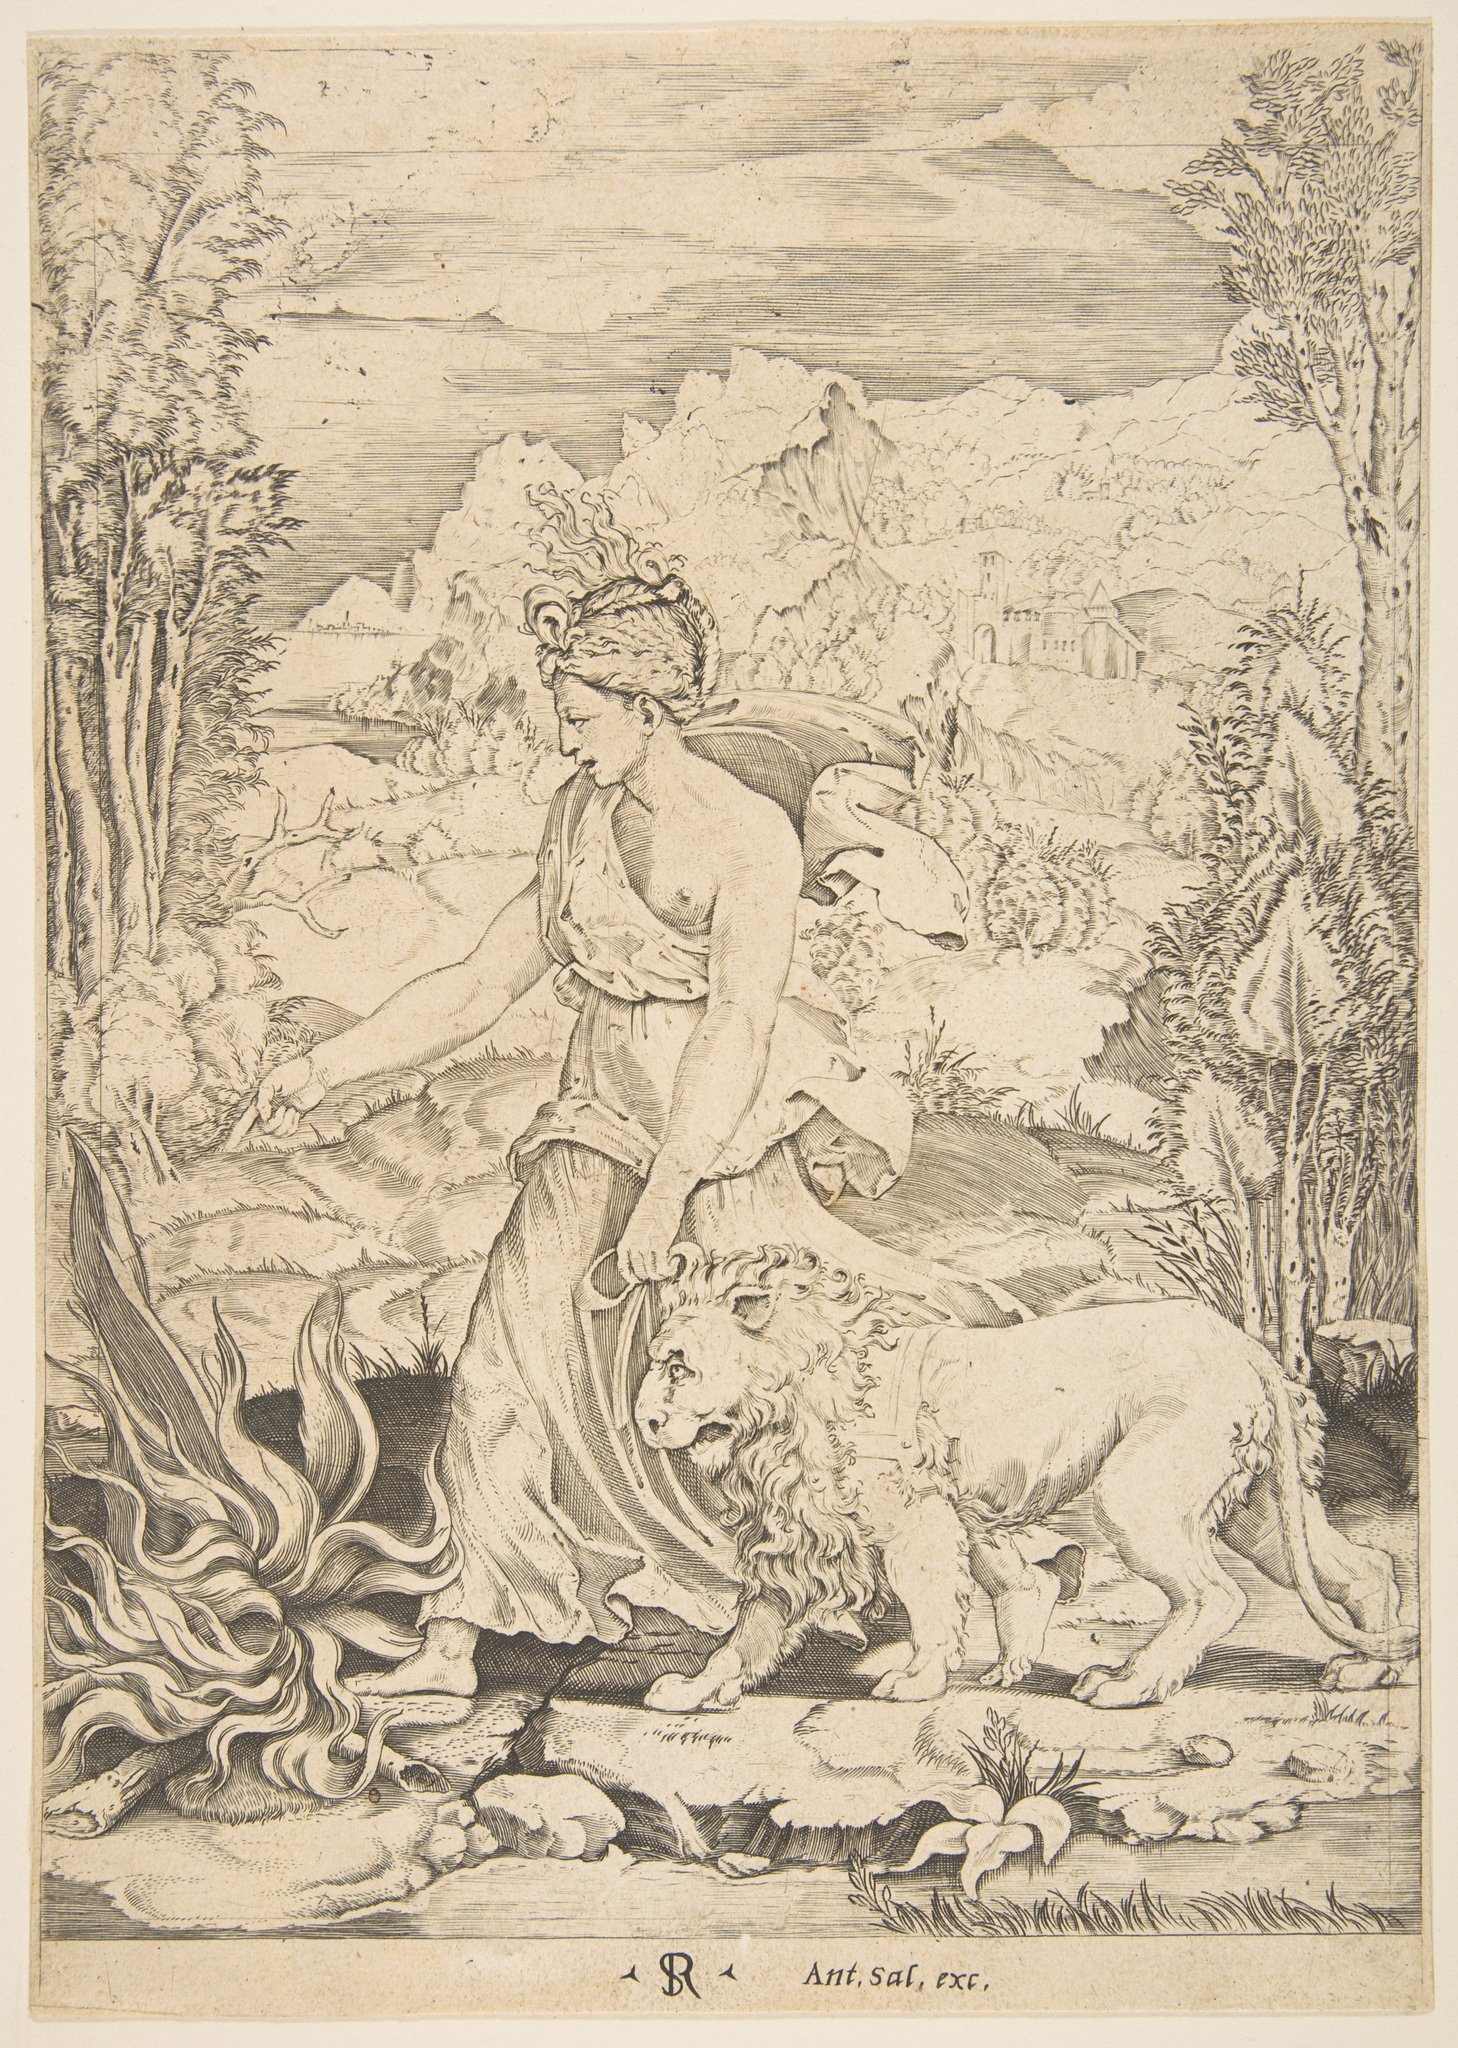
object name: print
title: Fortitude in profile view walking toward a fire at left and leading a harnessed lion, a landscape in the background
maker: marco dente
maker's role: artist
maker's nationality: italian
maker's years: 1515-1527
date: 1515-1527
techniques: engraving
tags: women,lions,fire,landscapes